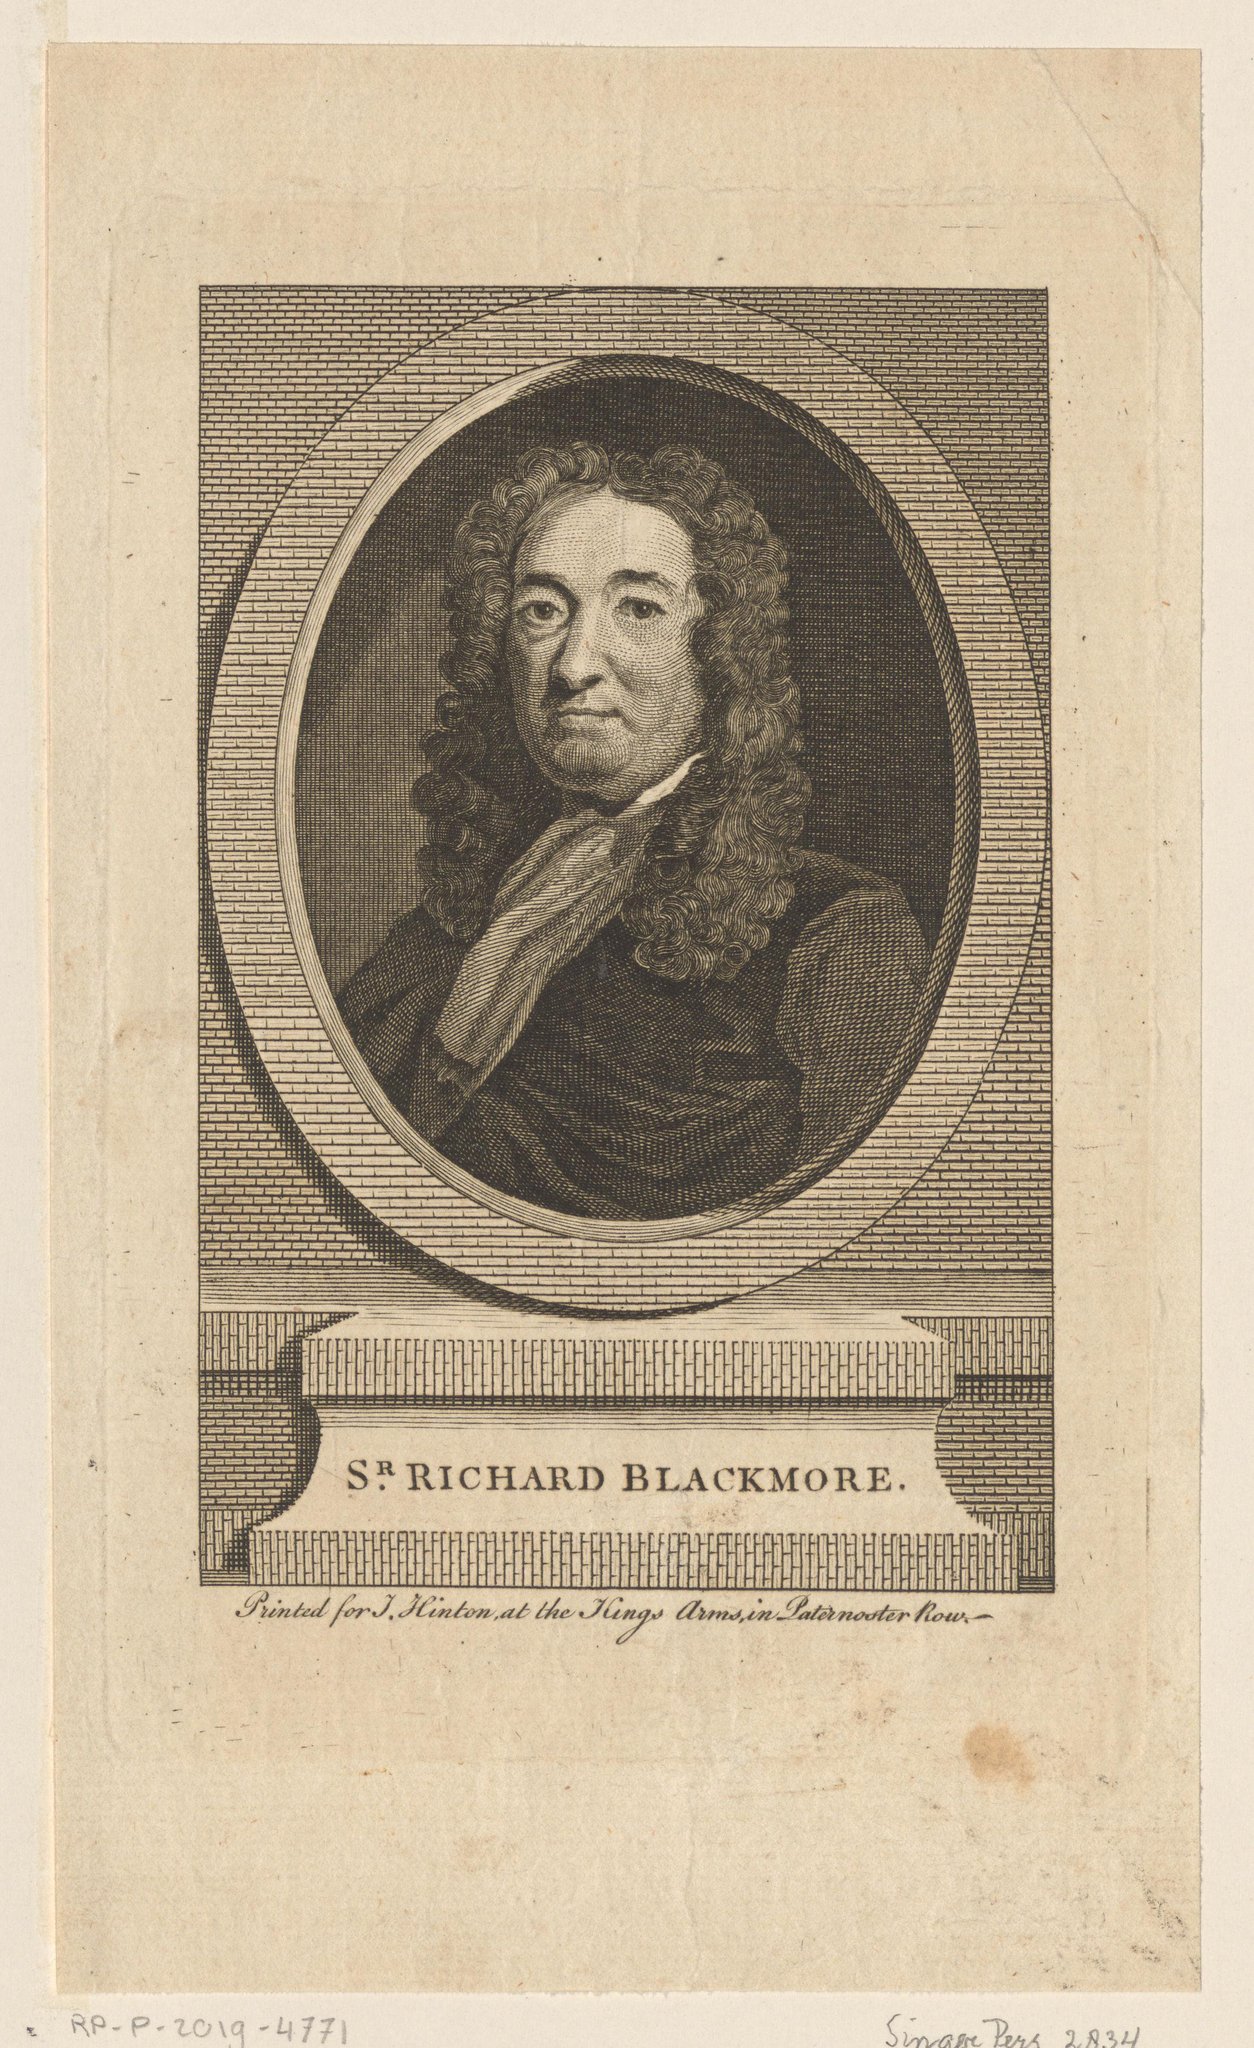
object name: print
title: Portret van Richard Blackmore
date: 1739-1781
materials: paper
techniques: engraving, etching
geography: london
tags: historical persons, writer, poet, author